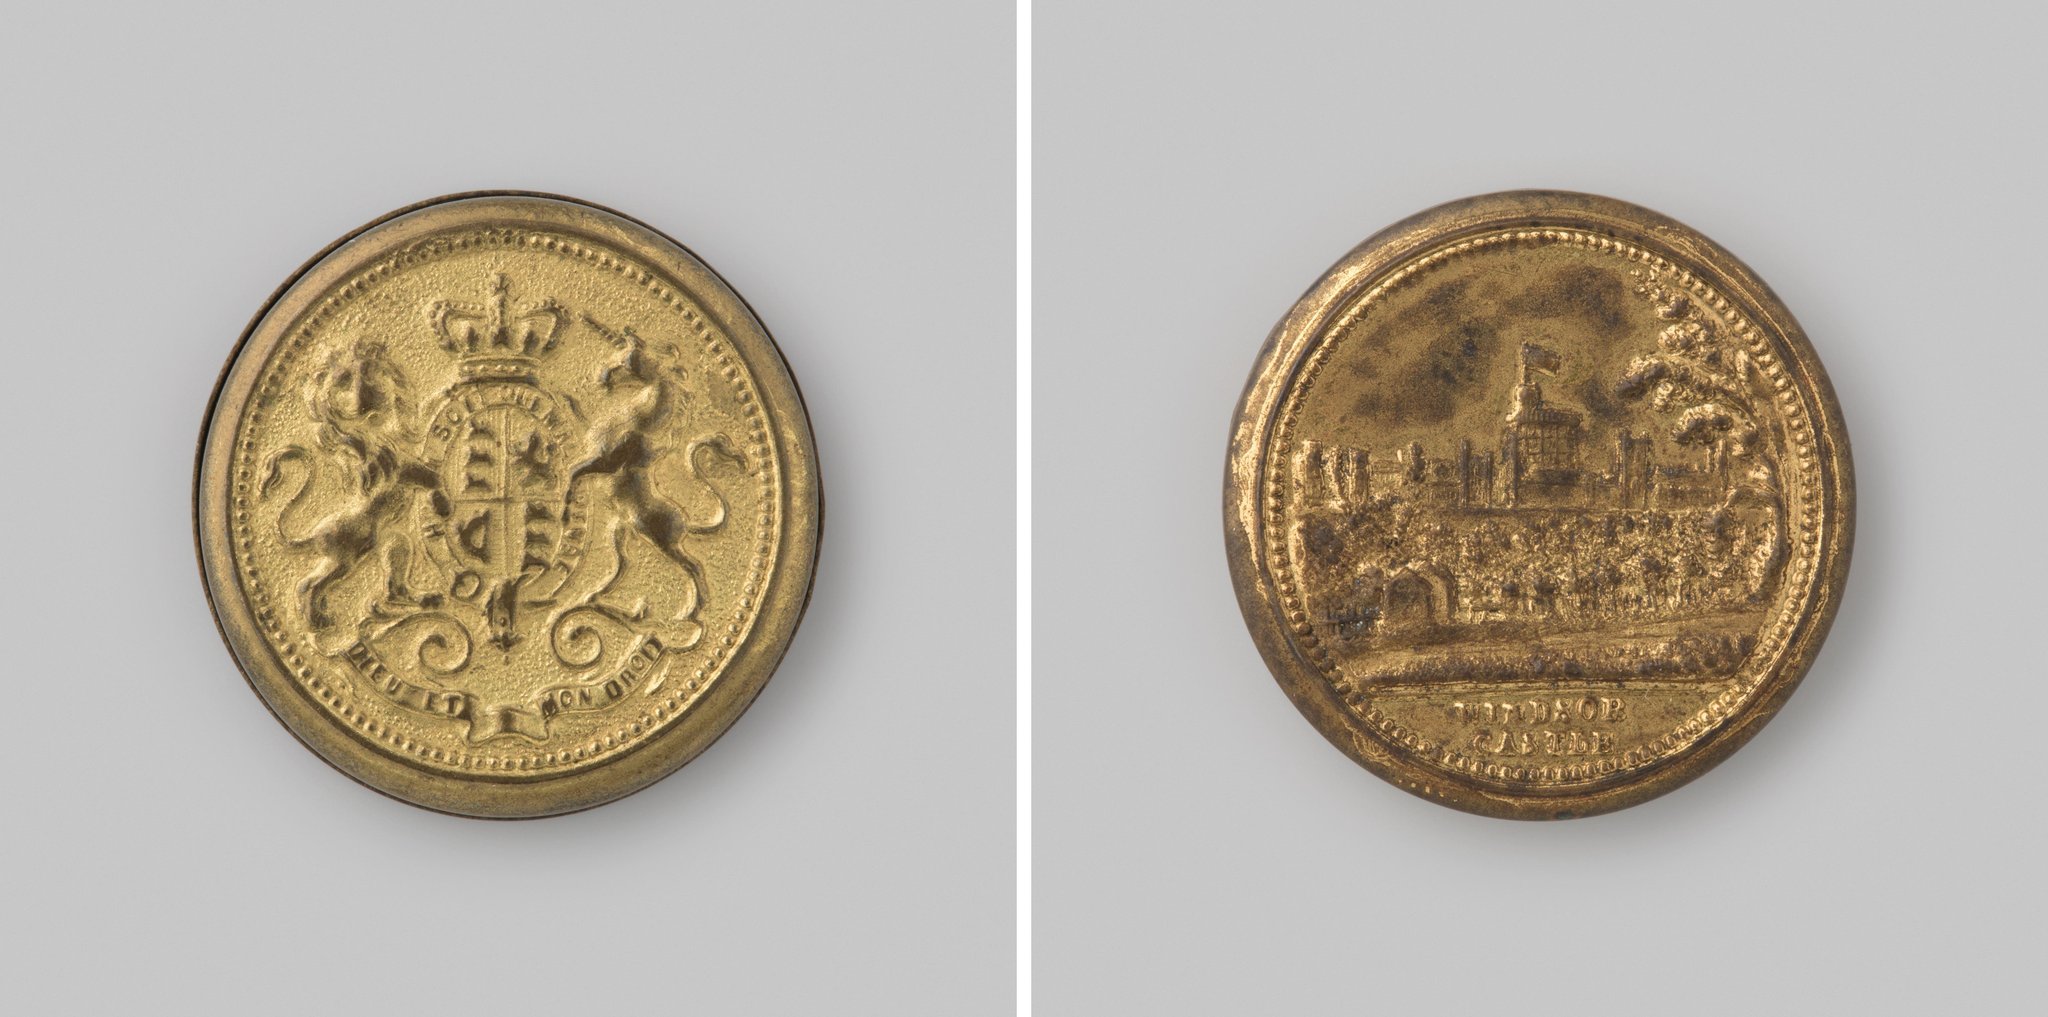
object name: history medal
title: "Windsor Castle" doosje met miniatuurpenningen met het portret van leden van de Engelse koninklijke familie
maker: joseph moore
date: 1850-1890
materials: brass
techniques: pressing, striking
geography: birmingham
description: Klein messing doosje met deksel, met reliëfafbeelding van het Britse wapen met dragers resp. Windsor Castle, inhoudend vijf miniatuurpenningen op naam van Koningin Victoria (10 mm) en de prinsessen Alice (3x) en Louisa (8 mm).